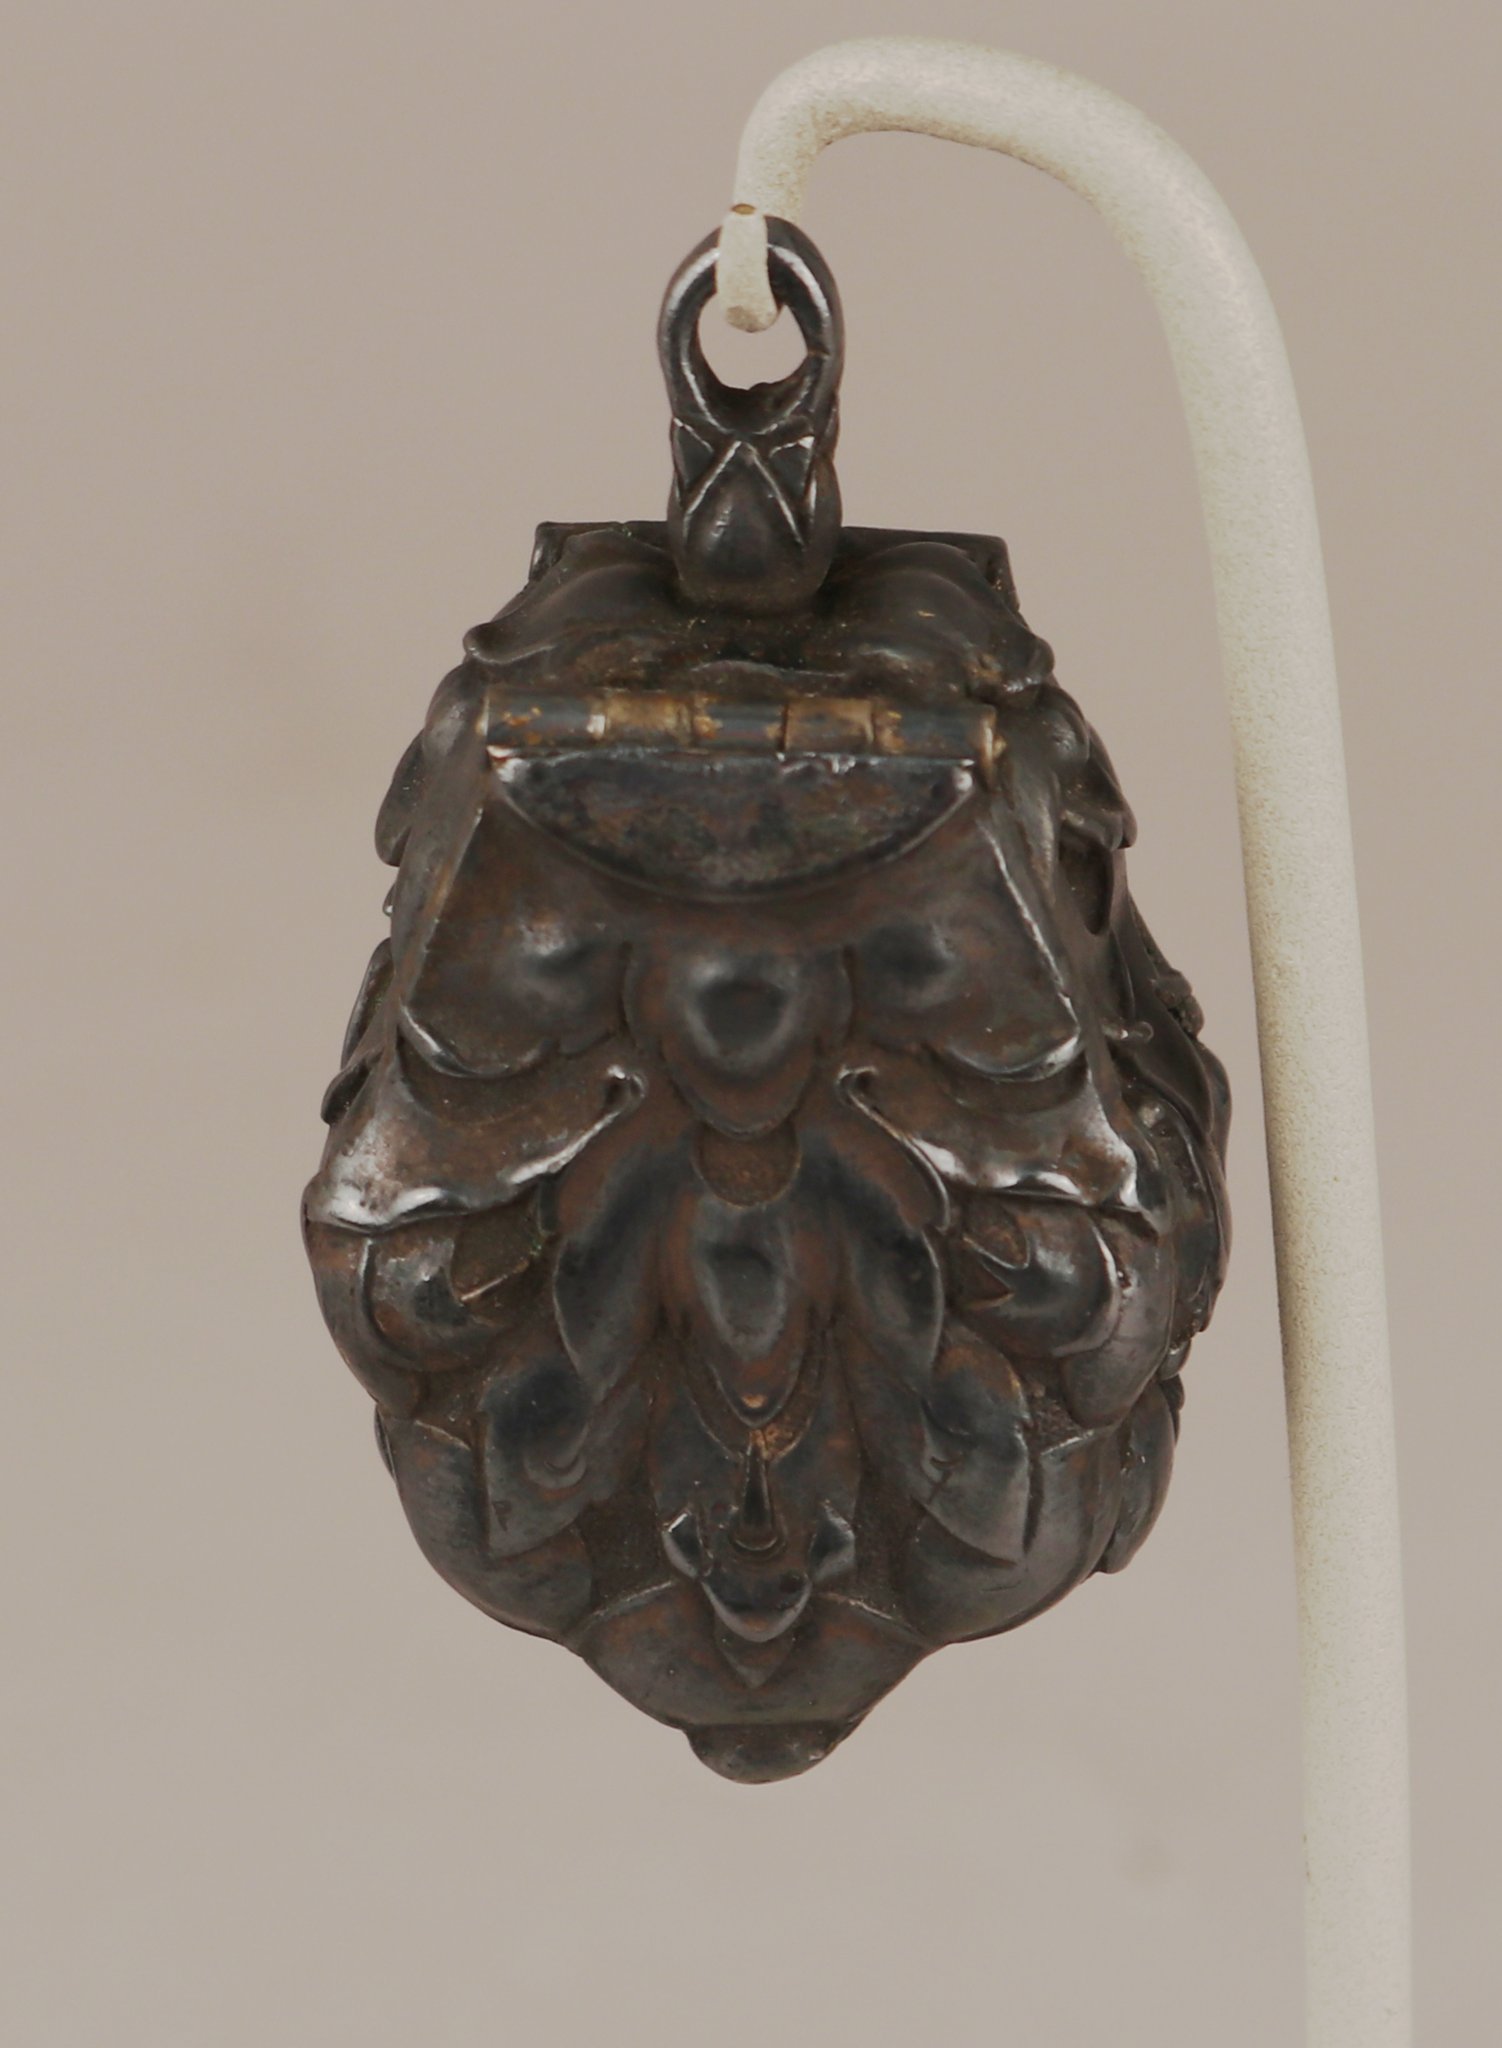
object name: watch case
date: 1801-1900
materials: silver